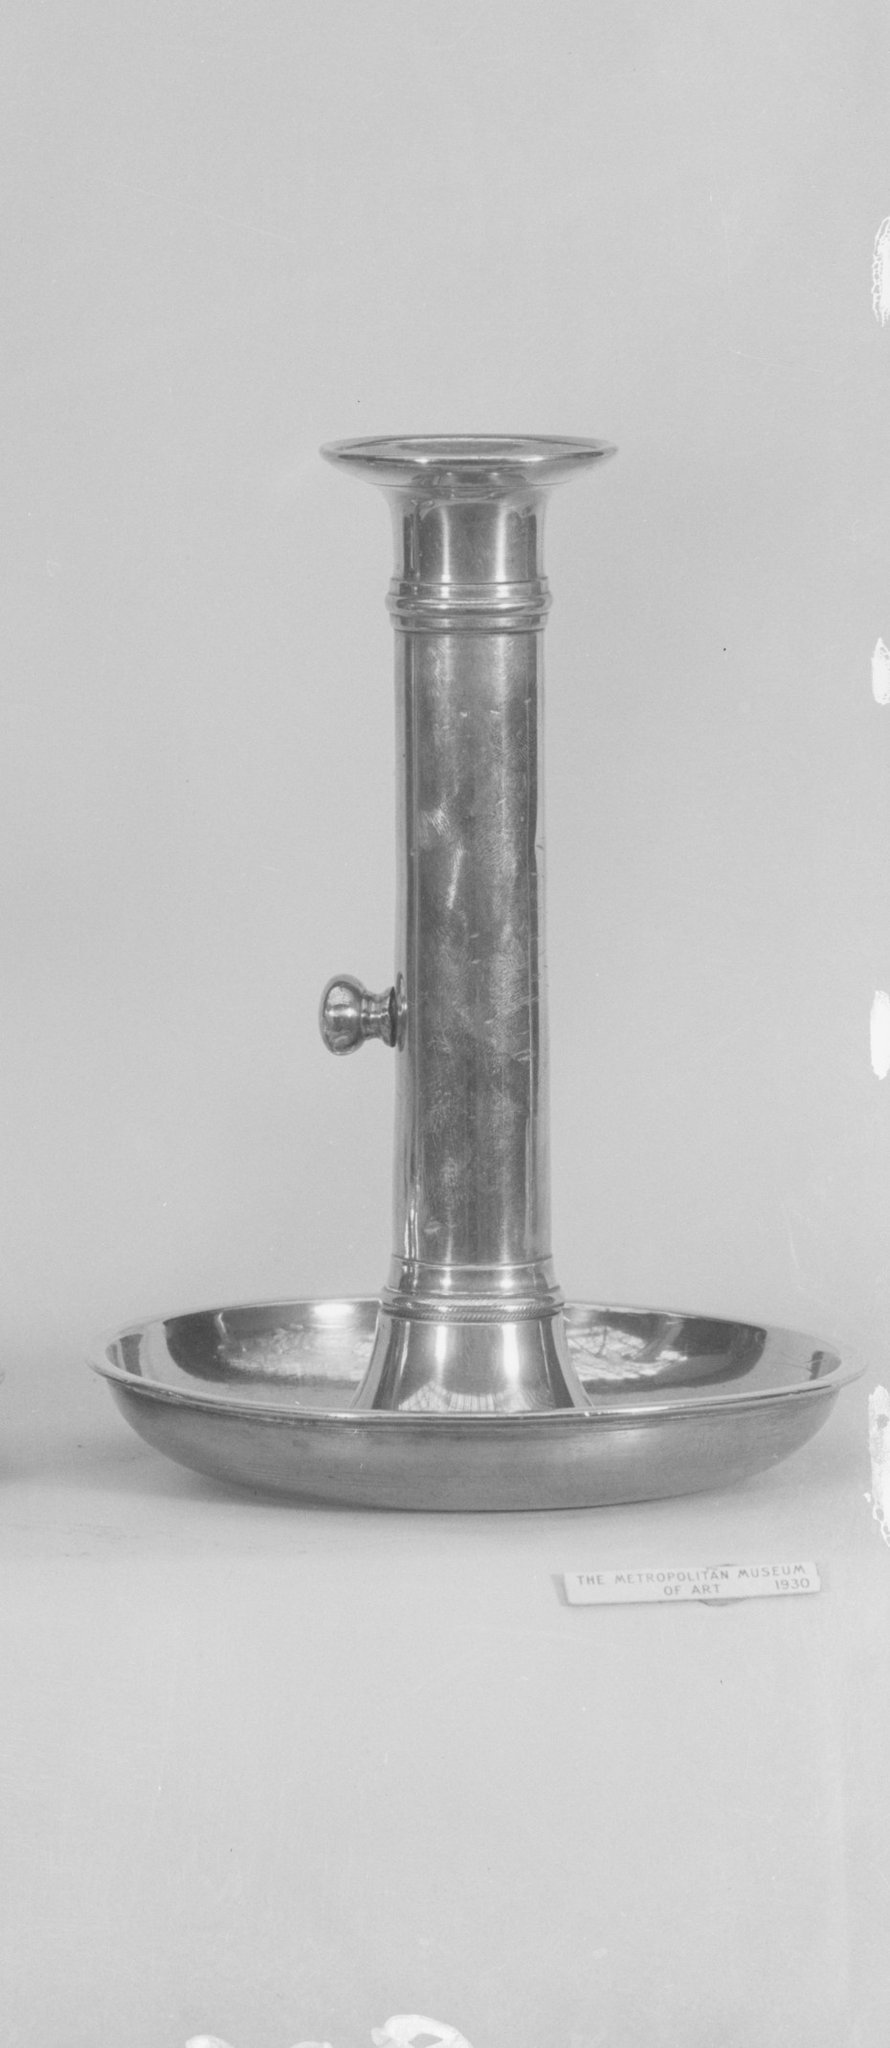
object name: candlestick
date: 1790-1820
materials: brass